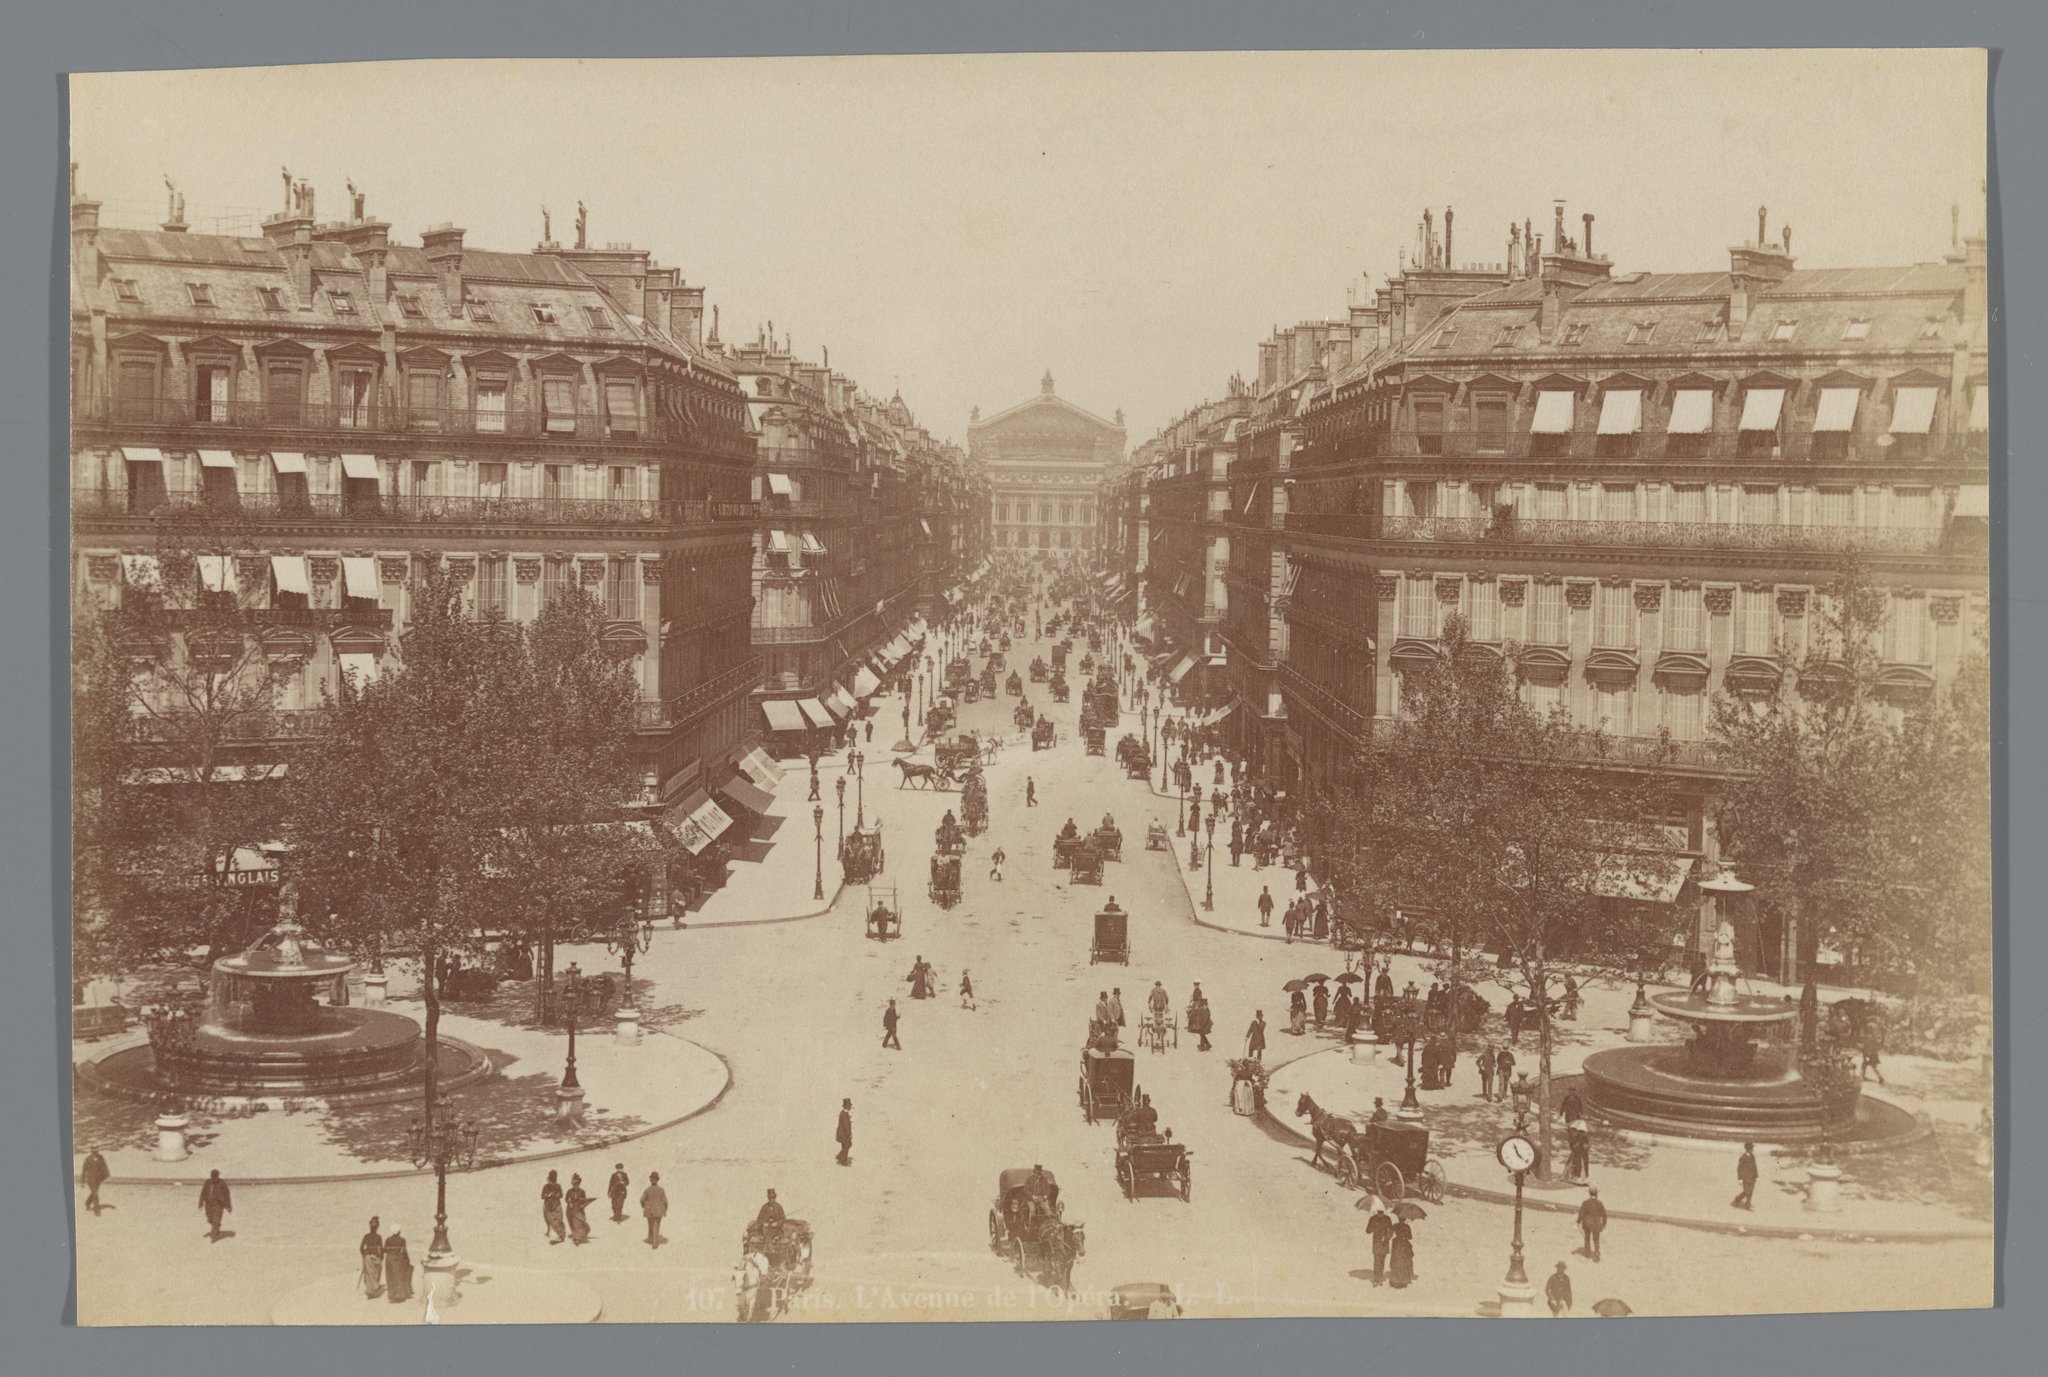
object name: photograph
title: Paris.- L'Avenue de l'Opéra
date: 1870-1890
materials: paper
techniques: albumen print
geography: paris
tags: avenue, boulevard, promenade, esplanade, opera house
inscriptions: number: ‘107’, stamp: ‘F. Hélaine/ 214, Rue de Rivoli, 214/ Paris’, inscription: ‘Parijs. Avenue de l'Opera’